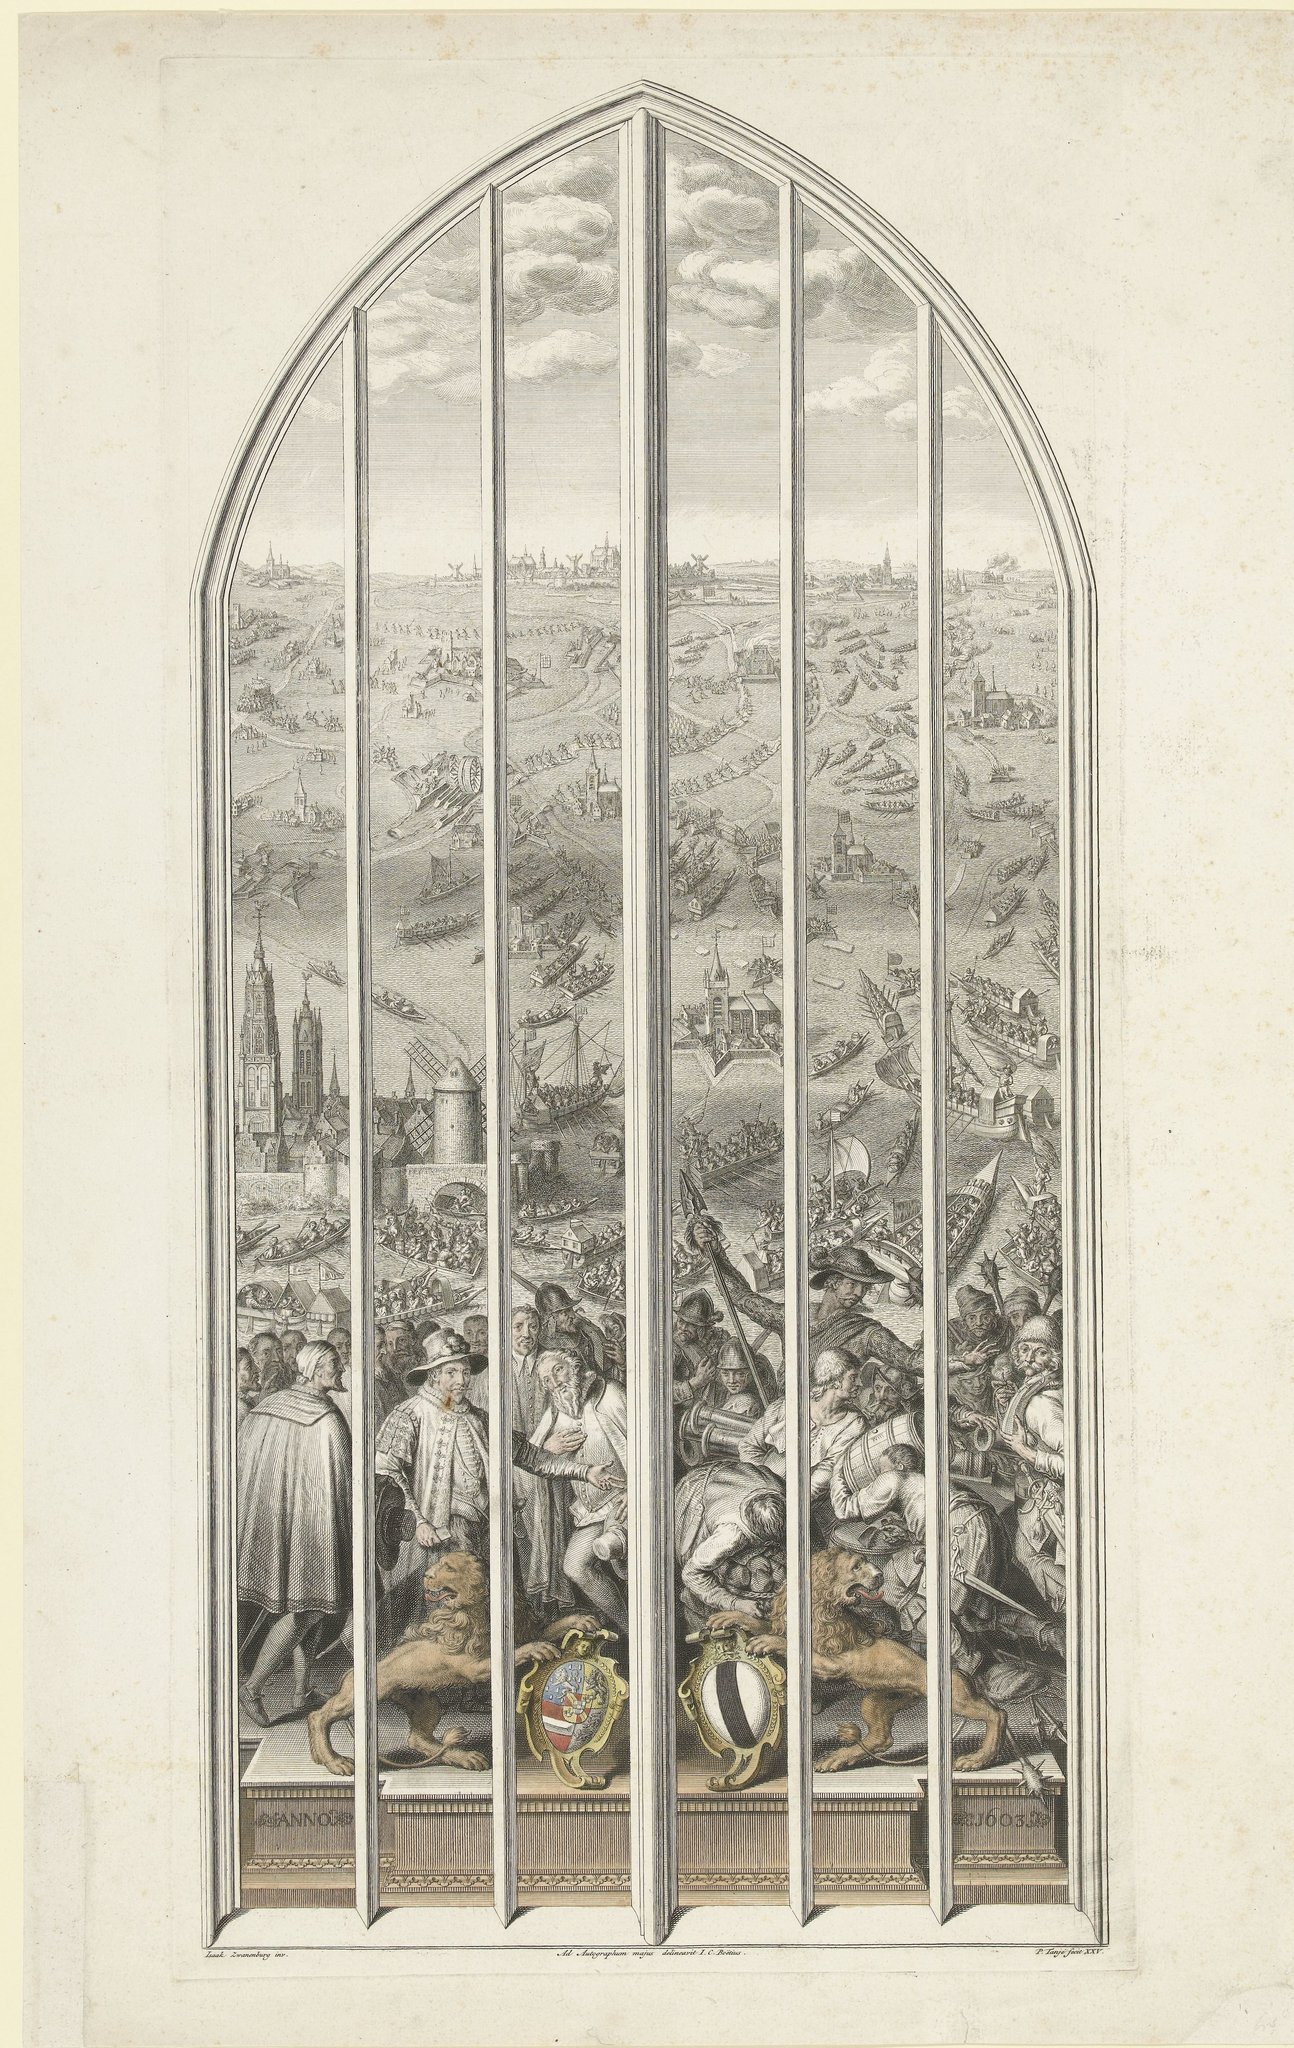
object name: historical object representation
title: Goudse glazen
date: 1738-1754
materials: paper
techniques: etching, hand coloring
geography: amsterdam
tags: william i (prince of orange), raising the siege with outside assistance, relief, church-window, e.g. rose-window, leiden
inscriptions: collector's mark: Lugt 2228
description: Het vijfentwintigste glasraam in de Sint-Janskerk te Gouda met de voorstelling van het ontzet van Leiden op 3 oktober 1574. Op de voorgrond prins Willem I van Oranje staande tussen Leidenaren, soldaten en geuzen. Op de achtergrond vertrekken de boten van de geuzen richting Leiden. Onderaan: Anno 1603.